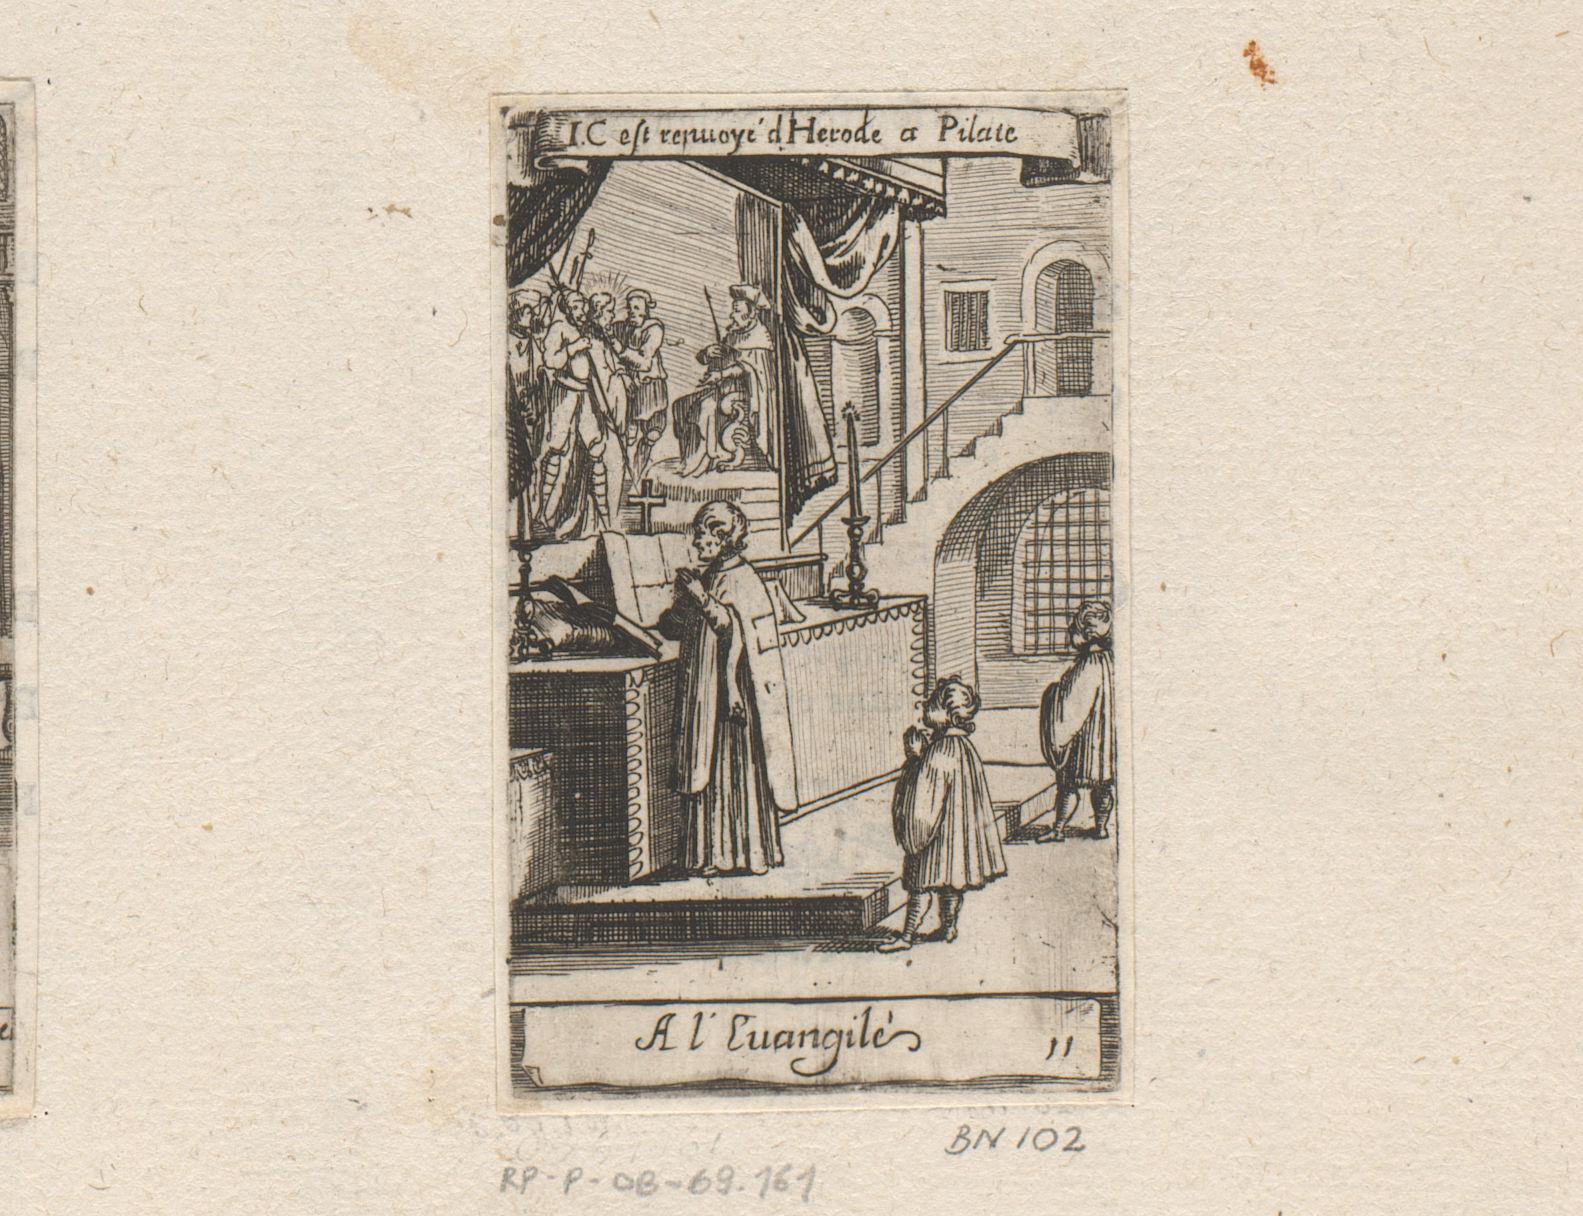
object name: book illustration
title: A l'Evangile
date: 1661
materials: paper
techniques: etching, letterpress printing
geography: france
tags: priest (roman catholic), altar with altar-piece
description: Prent uit: Mengin, L. Tableaux ou sont representees la passion de N.S. Christ et les actions du prestre a la S. Messe (...). Metz: Claude Bouchard, 1661.